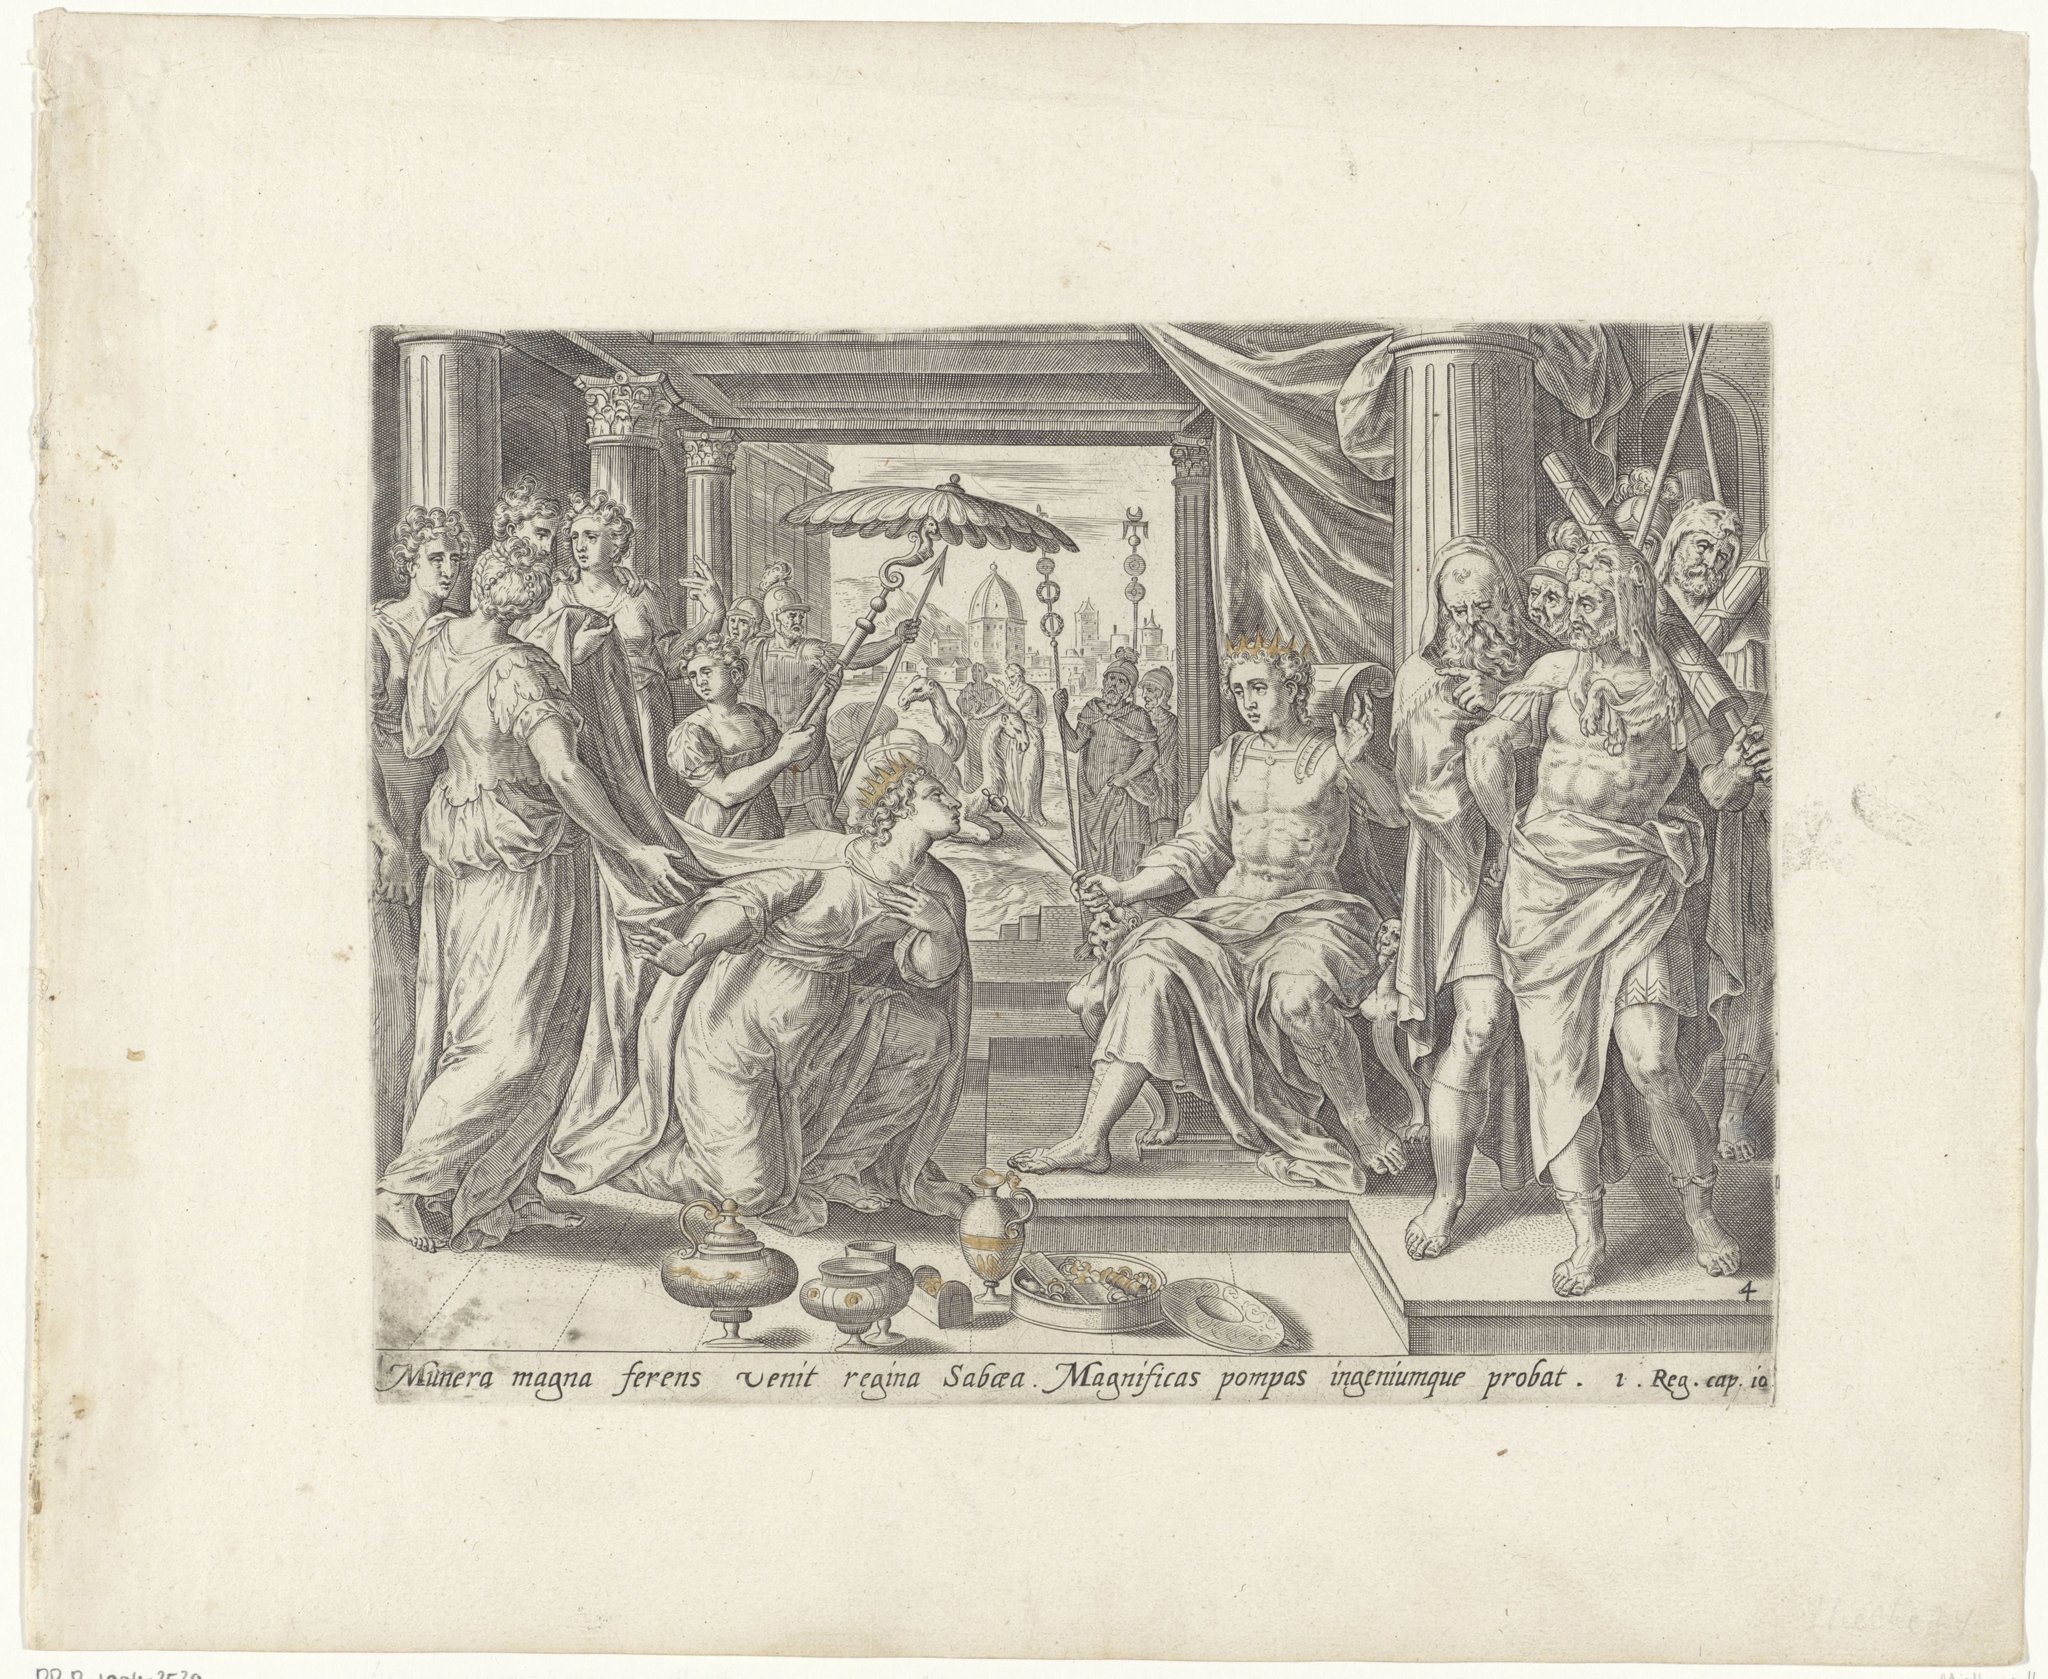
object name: print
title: Geschiedenis van Salomo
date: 1579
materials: paper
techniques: engraving, hand coloring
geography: amsterdam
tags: solomon and the queen of sheba (1 kings 10:1-3; 2 chronicles 9:1-9)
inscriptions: collector's mark: Lugt 2228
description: Prent gebruikt in: Theatrum biblicum : hoc est historiae sacrae veteris et novi testamenti tabulis aeneis expressae. Opus praesentatissimorum huius ac superioris seculi pictorum atque sculptorum, summo studio conquisitum et in lucem editum. Amsterdam: Claes Jansz. Visscher, 1643.